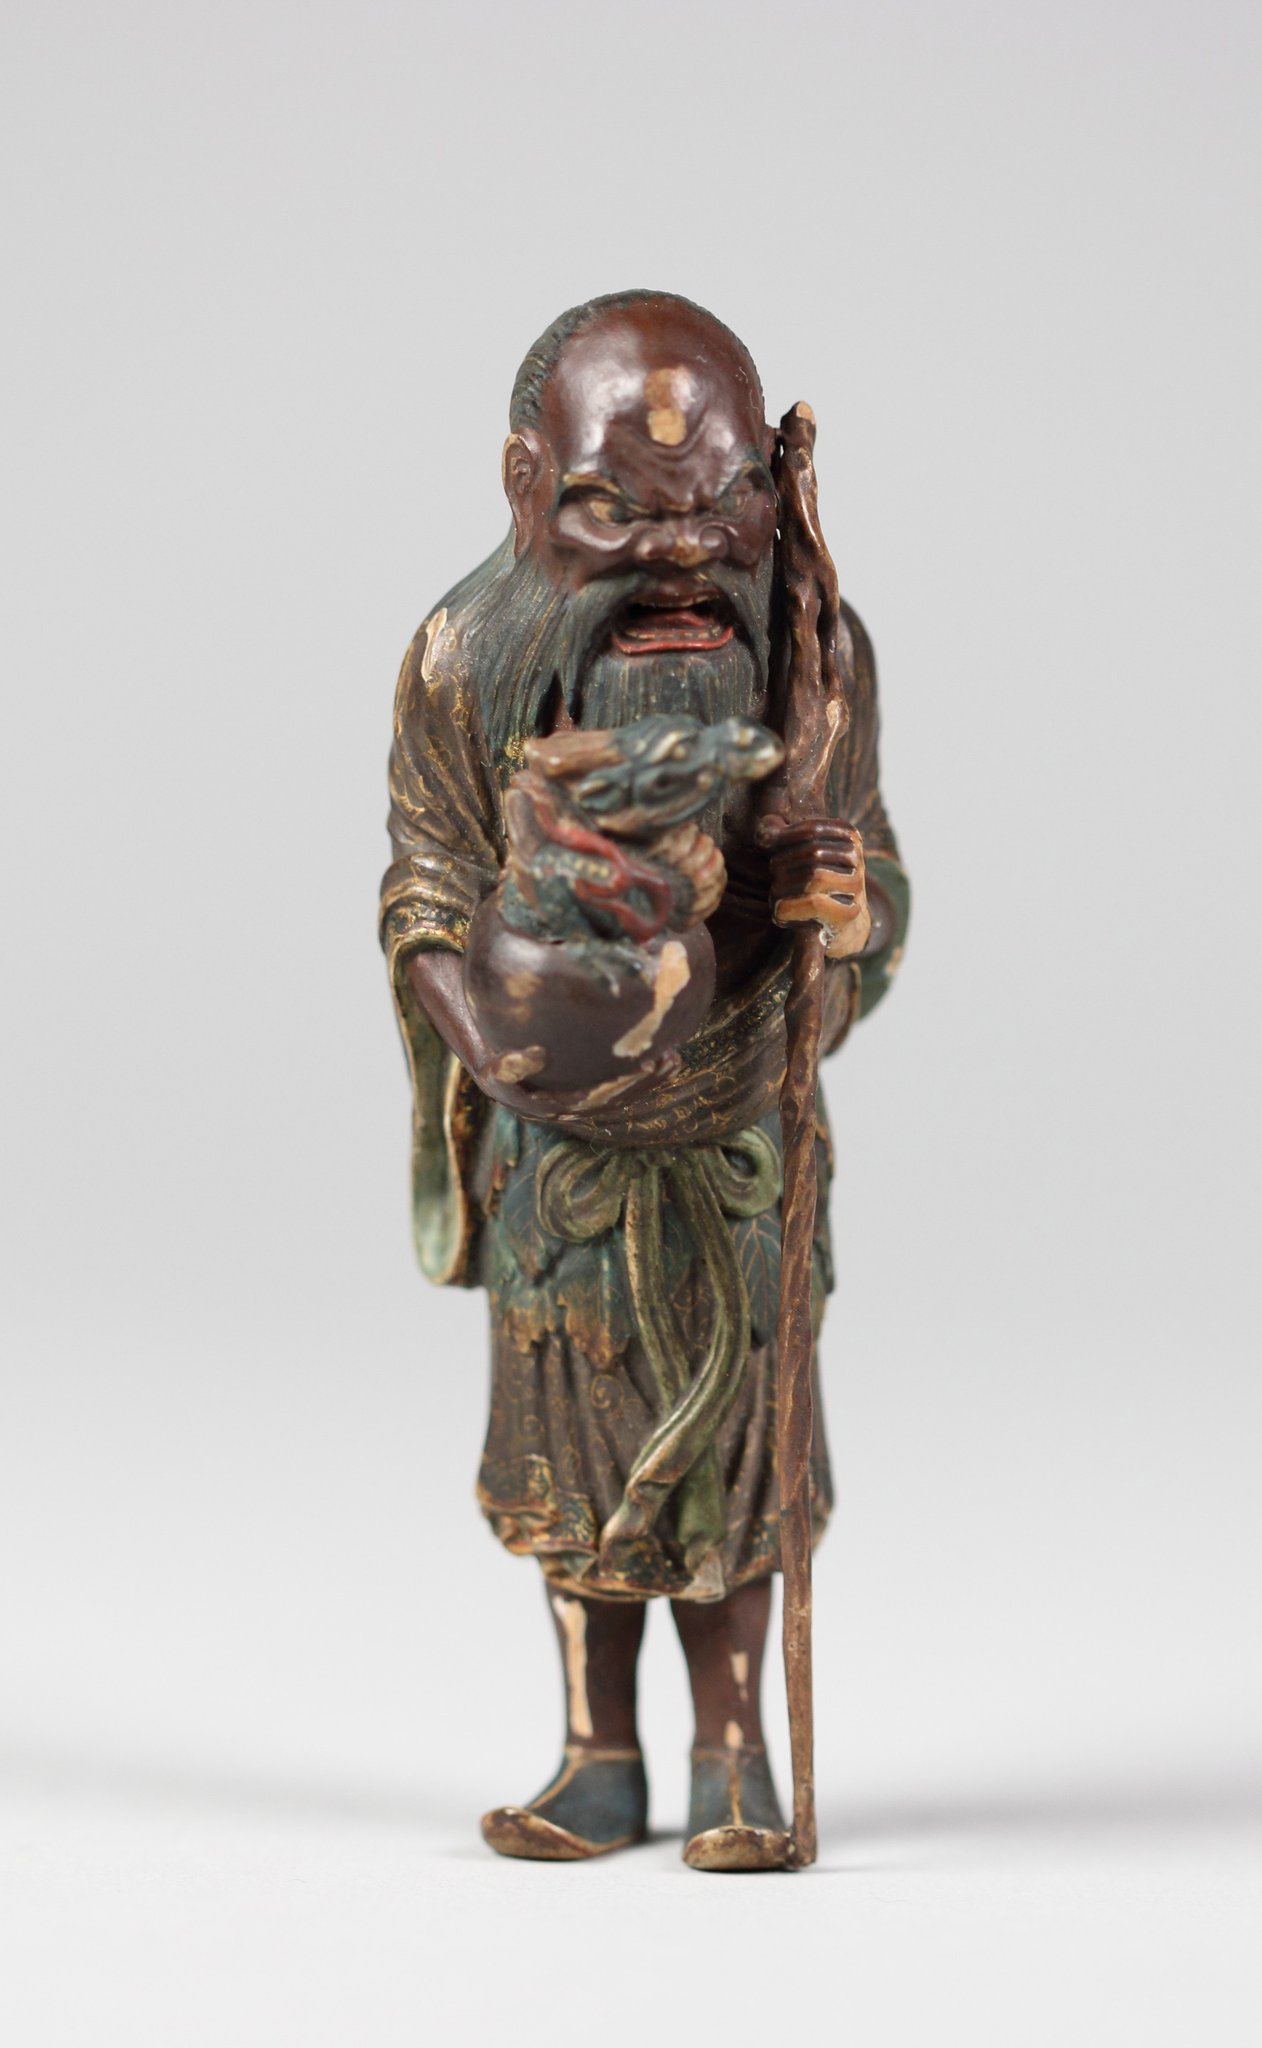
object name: netsuke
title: Netsuke of an Arhat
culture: japanese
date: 1801-1900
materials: wood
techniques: polychrome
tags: men